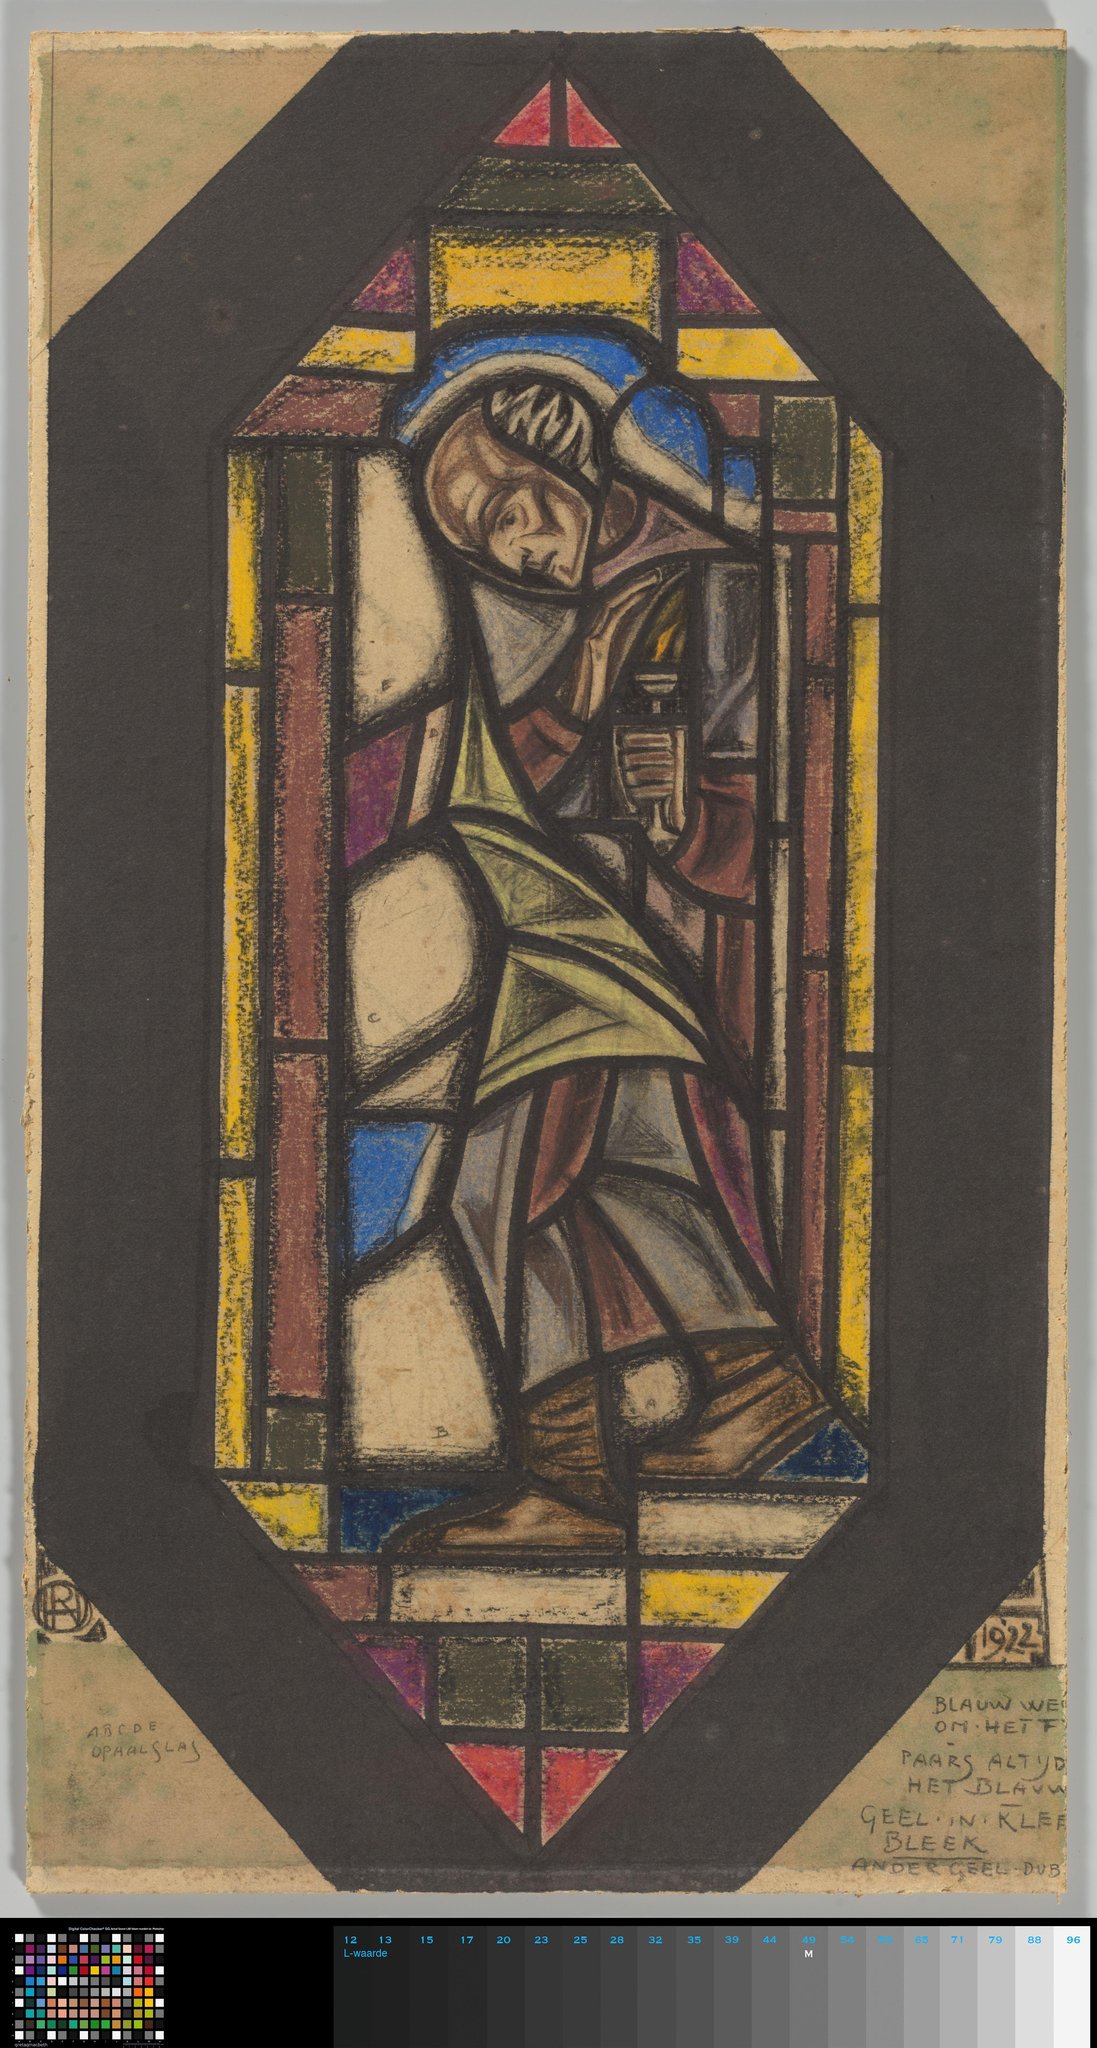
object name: drawing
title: De trap des levens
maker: richard nicolaüs roland holst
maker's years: 1868-1938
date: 1922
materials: cardboard, chalk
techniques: brush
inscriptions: monogram: ‘RNRH’